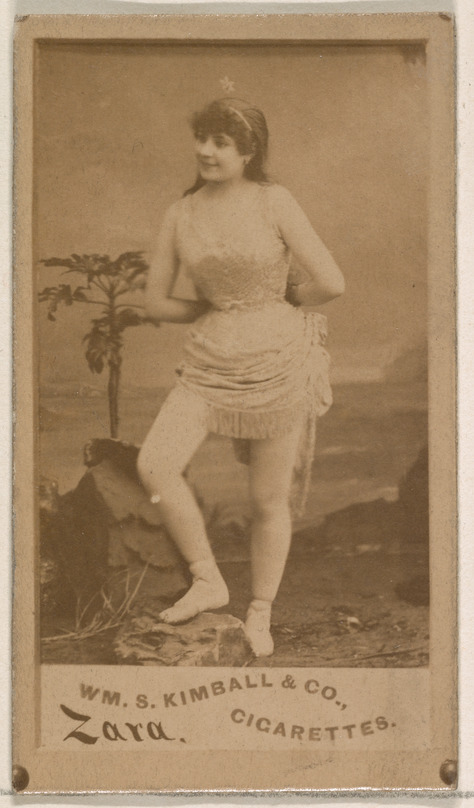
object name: photograph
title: Miss Zara, from the Actresses series (N203) issued by Wm. S. Kimball & Co.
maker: william s. kimball & company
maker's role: publisher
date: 1889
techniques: color lithograph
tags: portraits,women,actresses